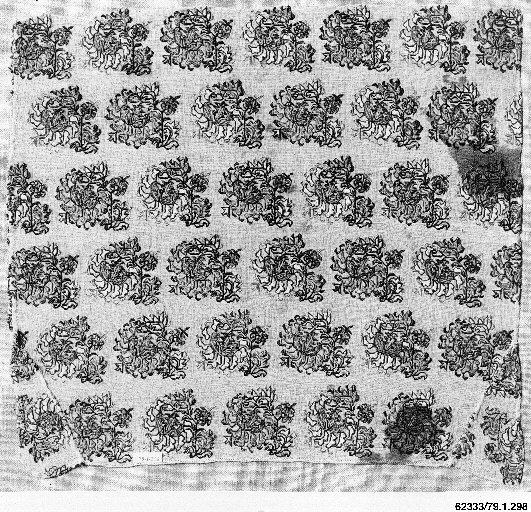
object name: textile fragment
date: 1701-1800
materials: linen, metal thread, silk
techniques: embroidery, weave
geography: turkey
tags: flowers